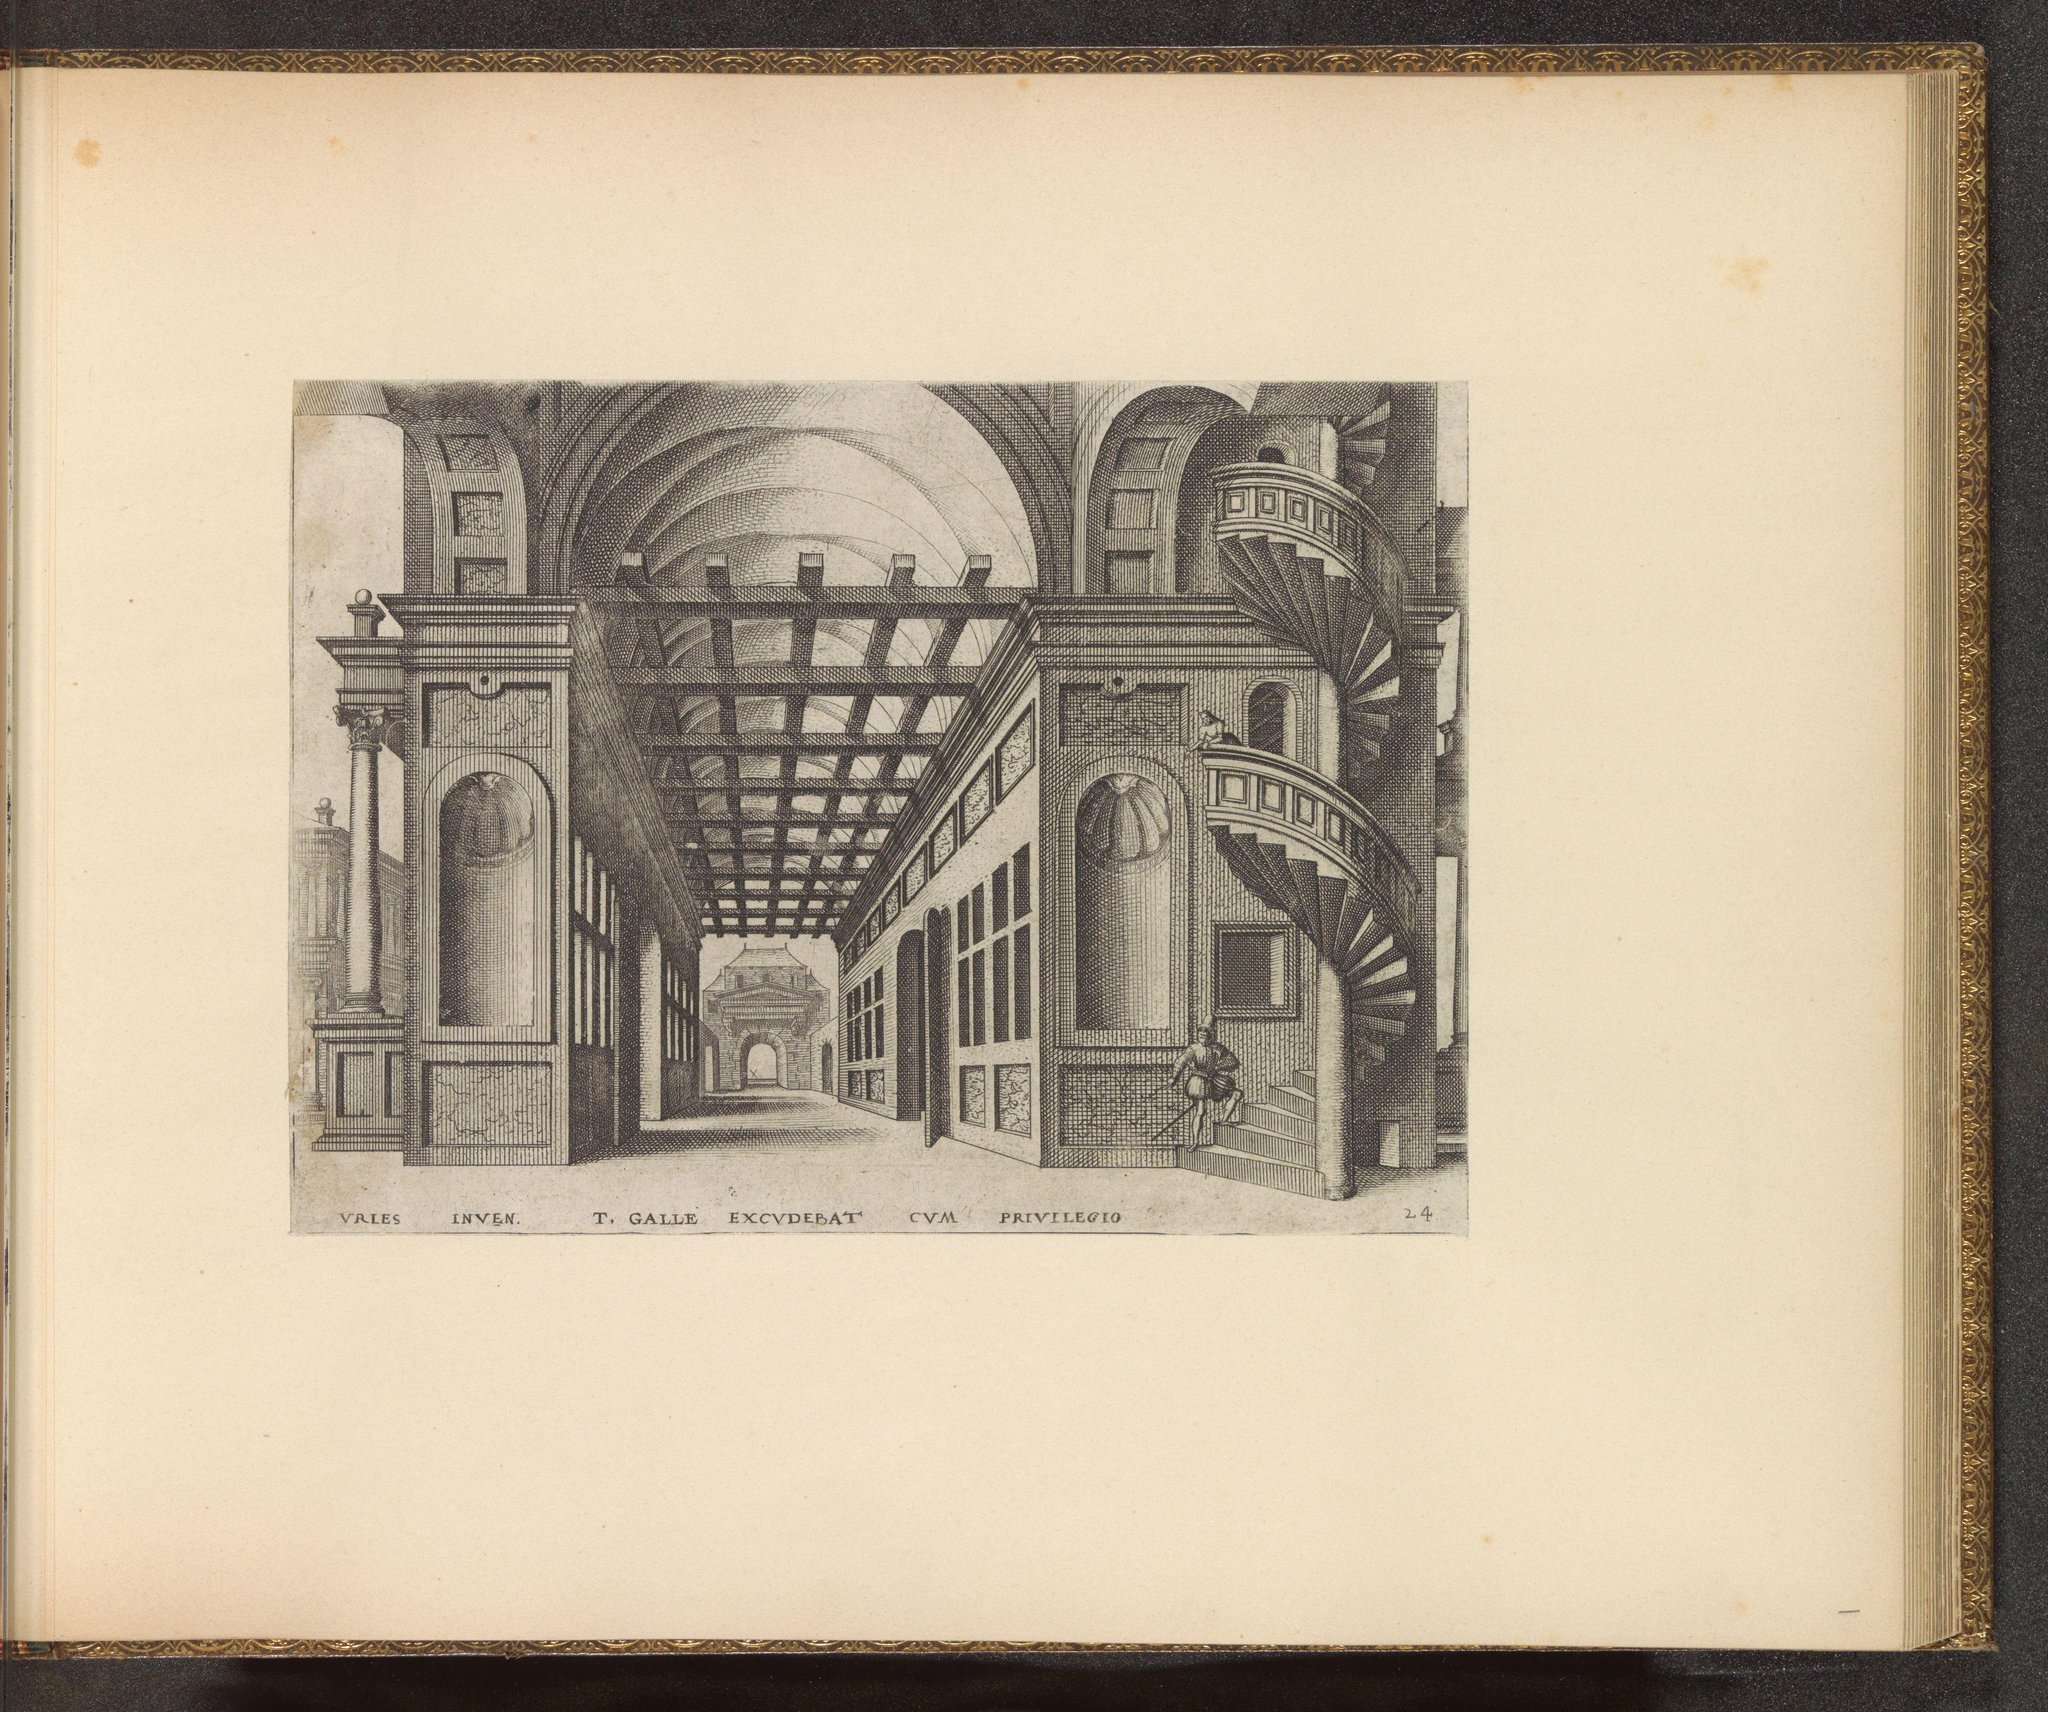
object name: album leaf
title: Architectuurperspectieven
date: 1601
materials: paper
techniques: etching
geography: antwerp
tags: gate, entrance, staircase, vault ~ architecture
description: Voorhal met een kruisgewelf en daaronder een open balkenrooster. Rechts staan twee mensen op een open wenteltrap. De prent maakt deel uit van een album.